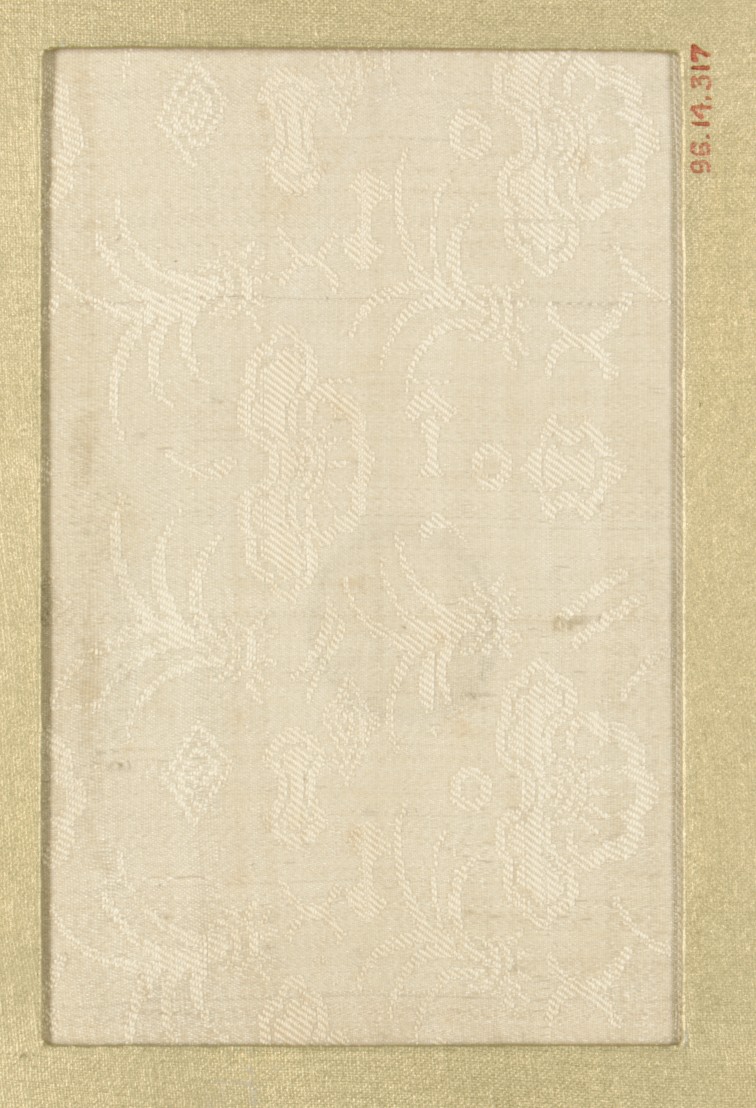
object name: piece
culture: japanese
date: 1701-1900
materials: silk